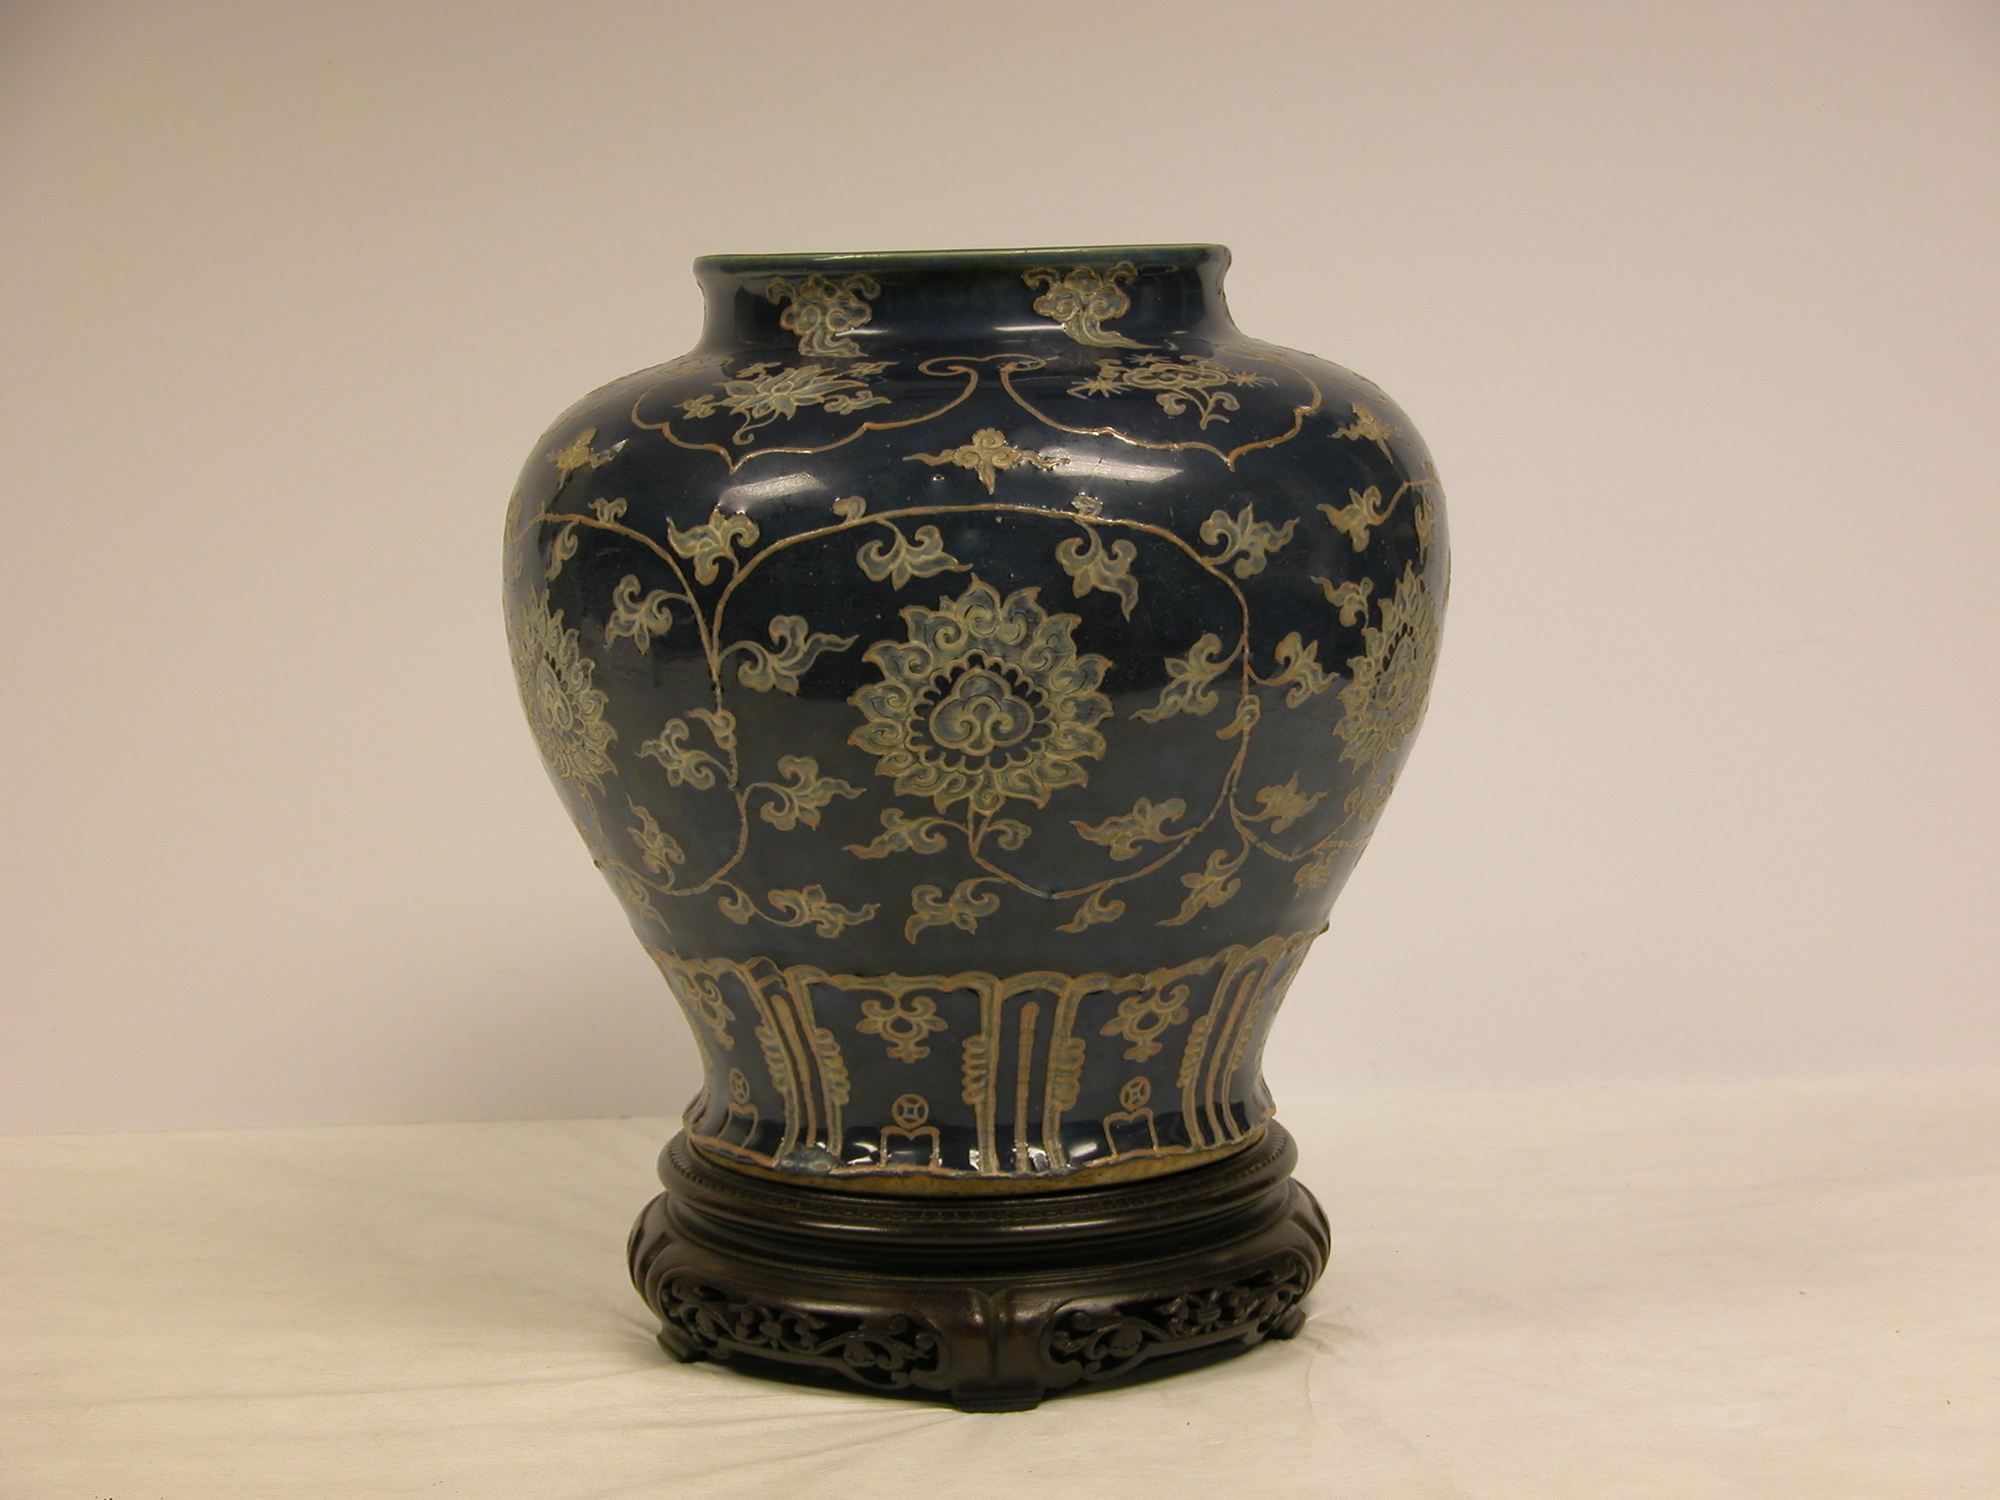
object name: vase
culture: chinese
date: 1368-1644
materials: porcelain